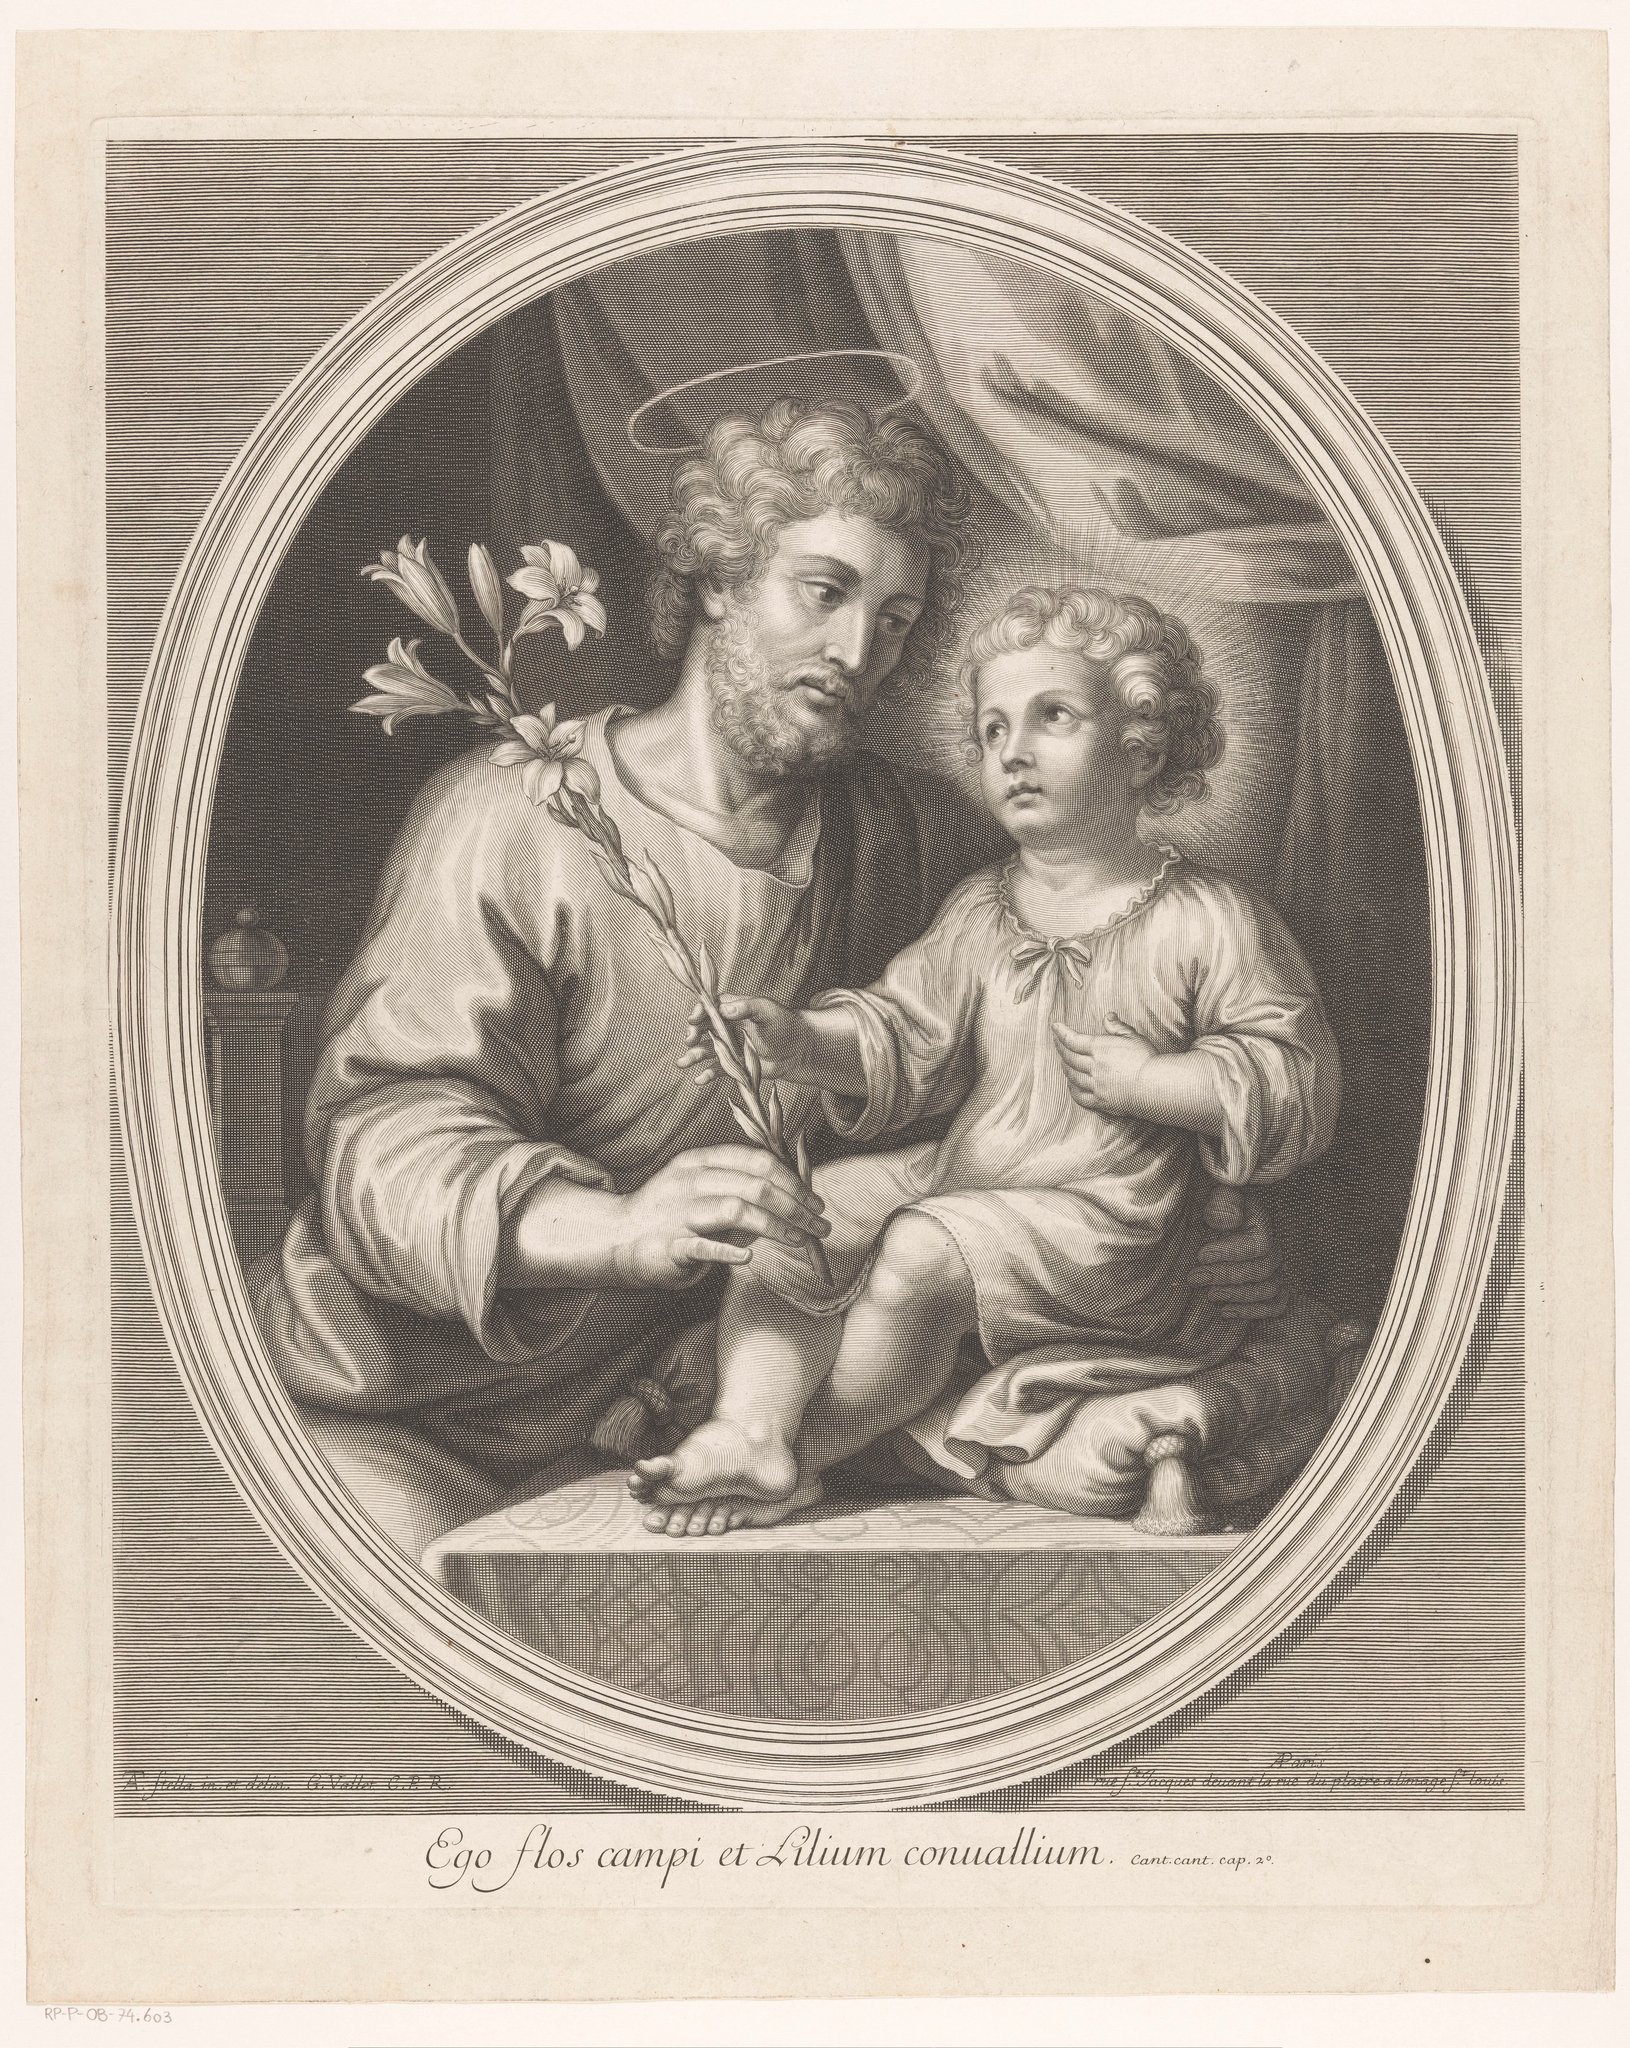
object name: print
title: Christuskind overhandigt de heilige Jozef een lelie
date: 1661-1704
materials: paper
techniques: engraving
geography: paris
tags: christ-child (with attributes), flowers: lily, the foster-father of christ, joseph of nazareth, husband of mary; possible attributes: flowering rod or wand, lily, carpenter's tools - male saint represented in a group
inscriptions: collector's mark: Lugt 240